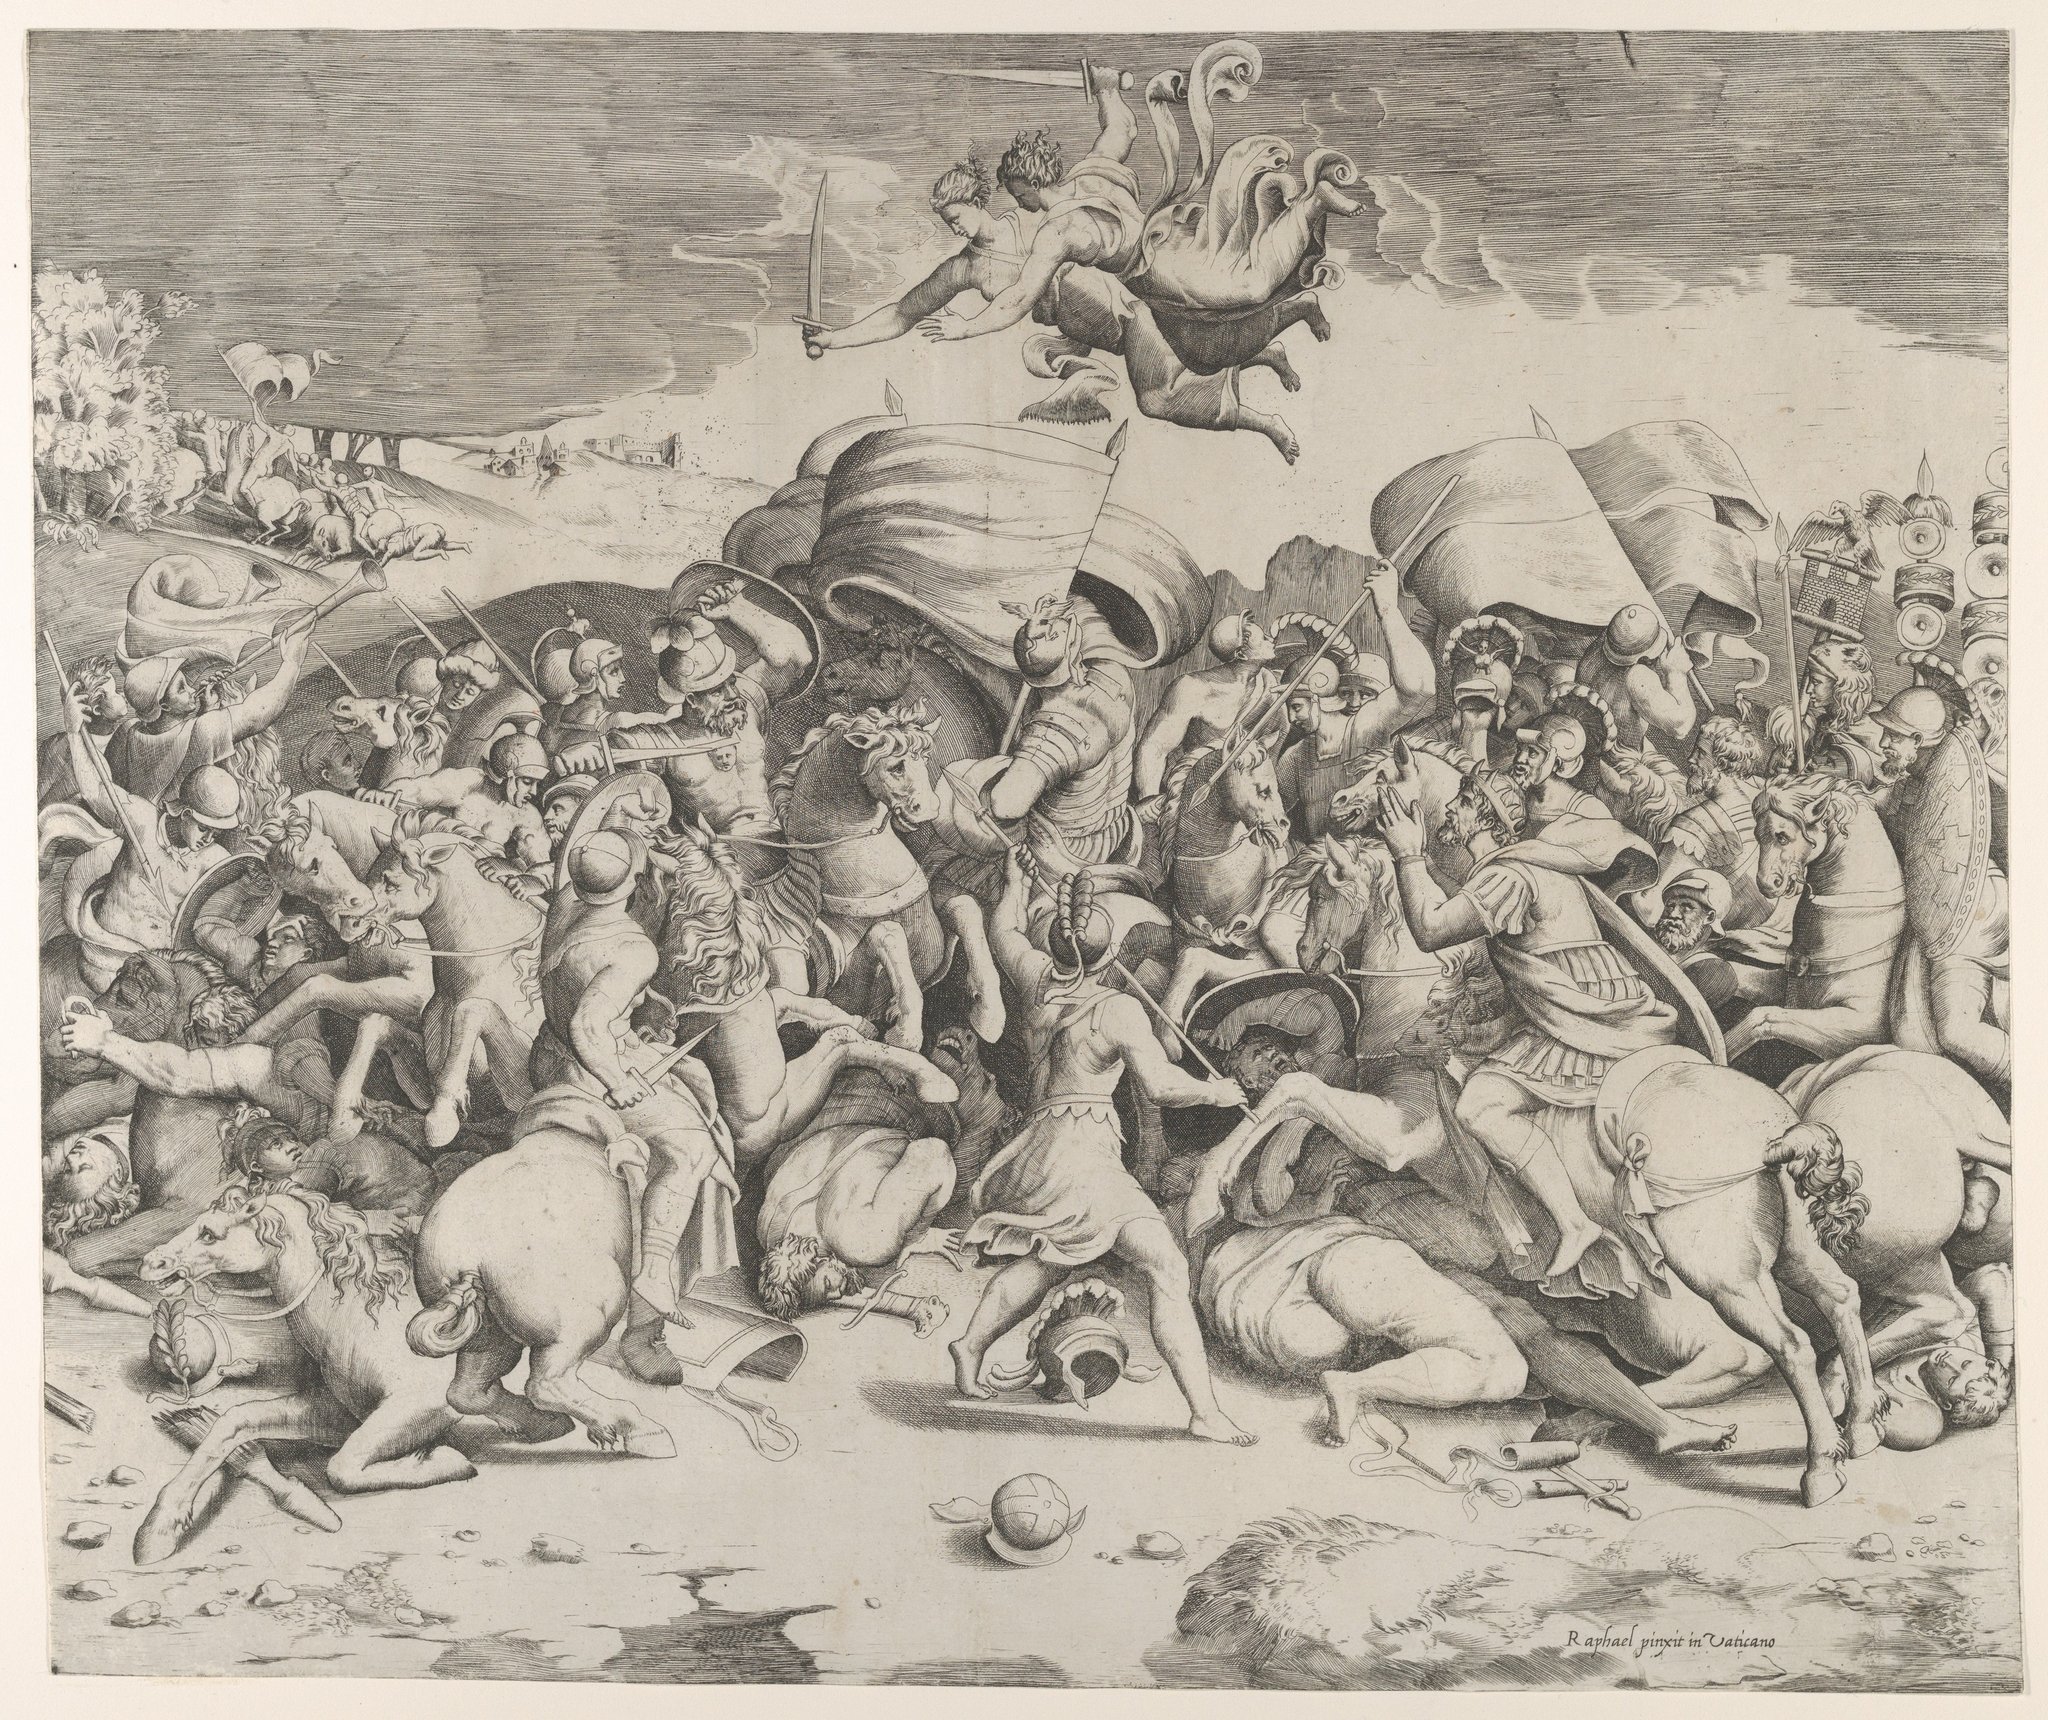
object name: print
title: Constantine defeating the tyrant Maxentius, angels carrying swords fly above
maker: giulio bonasone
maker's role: artist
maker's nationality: italian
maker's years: 1510-1576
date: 1544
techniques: engraving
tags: battles,soldiers,men,horses,angels